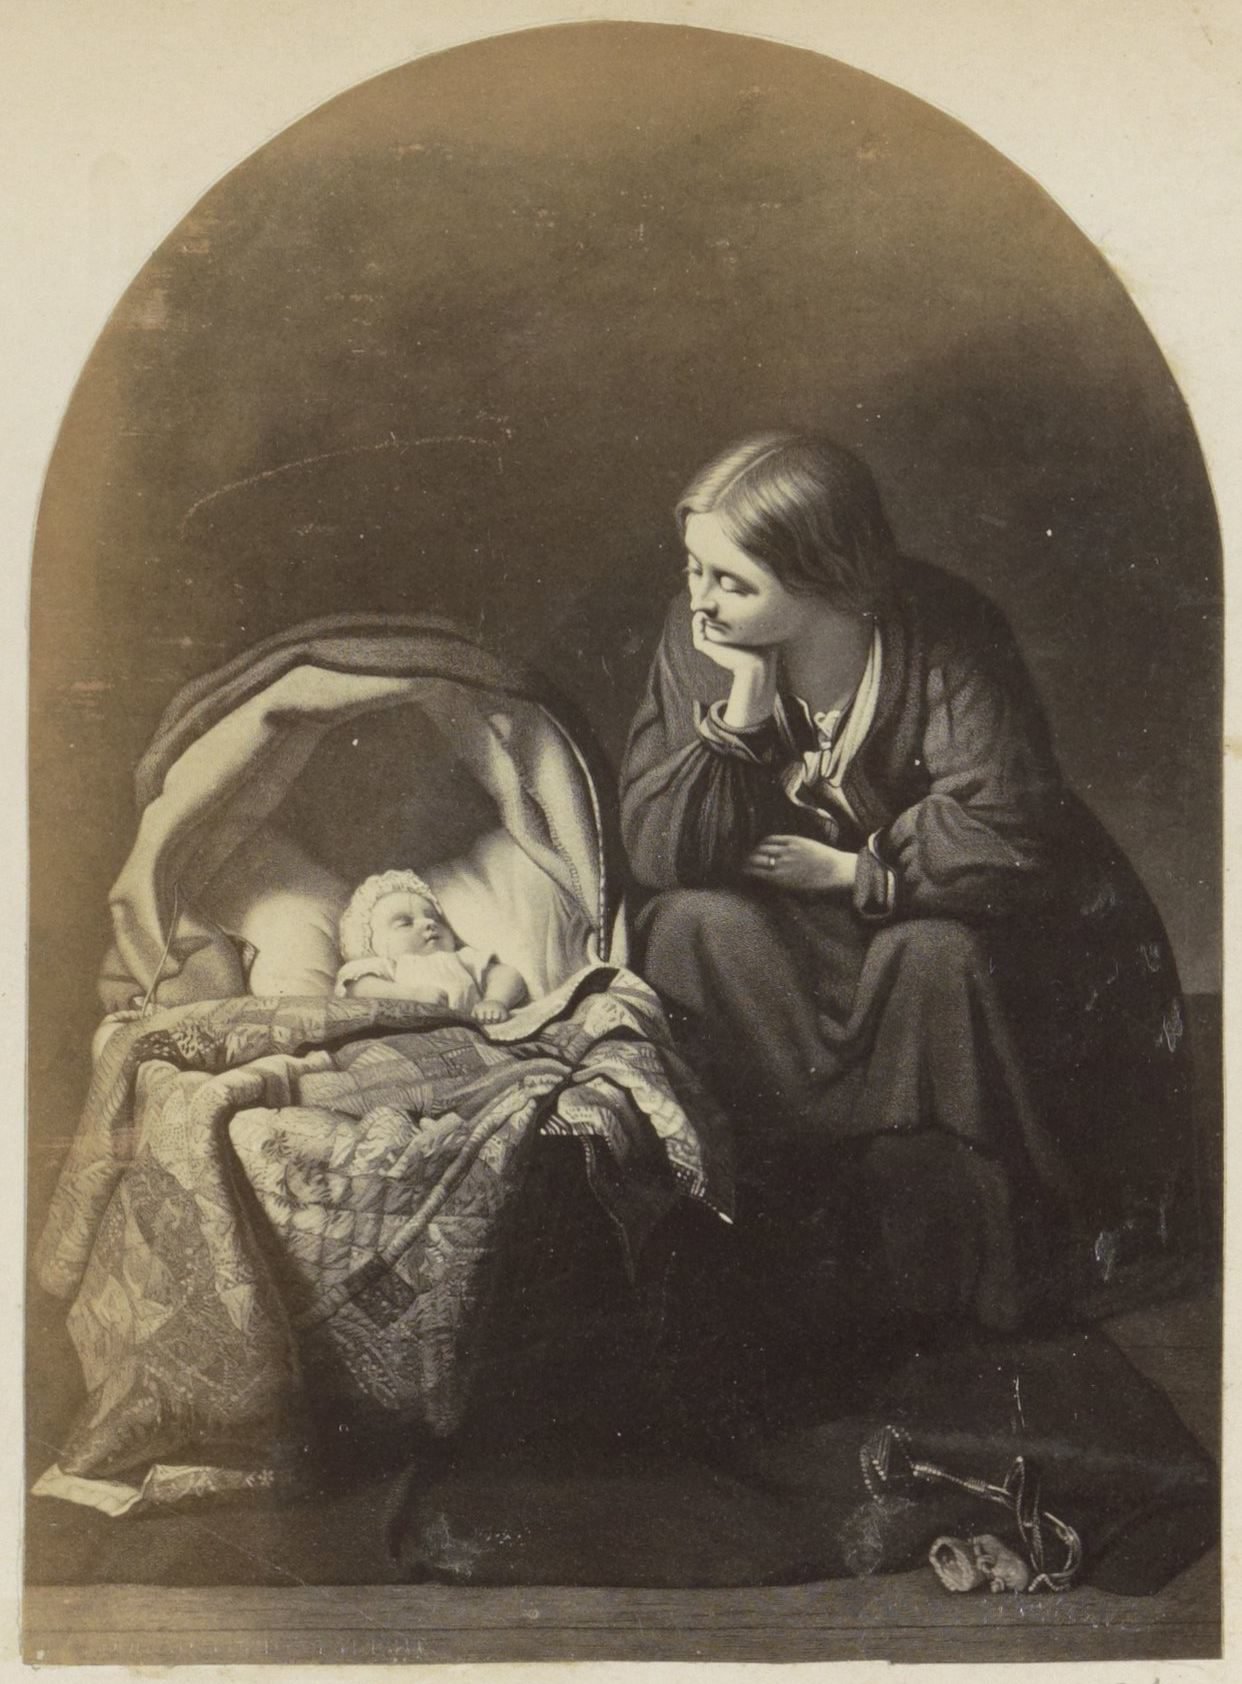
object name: reproduction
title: Fotoreproductie van (vermoedelijk) een schilderij van een moeder bij een wieg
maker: Anonymous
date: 1850-1870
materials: paper, photographic support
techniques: albumen print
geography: england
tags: cradle, crib, mother and baby or young child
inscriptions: check stamp: ‘[...]’, check stamp: ‘B. Brooks Oxford Copyright’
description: Onderdeel van Album met foto's van bezienswaardigheden en landschappen in Engeland en van kunst.